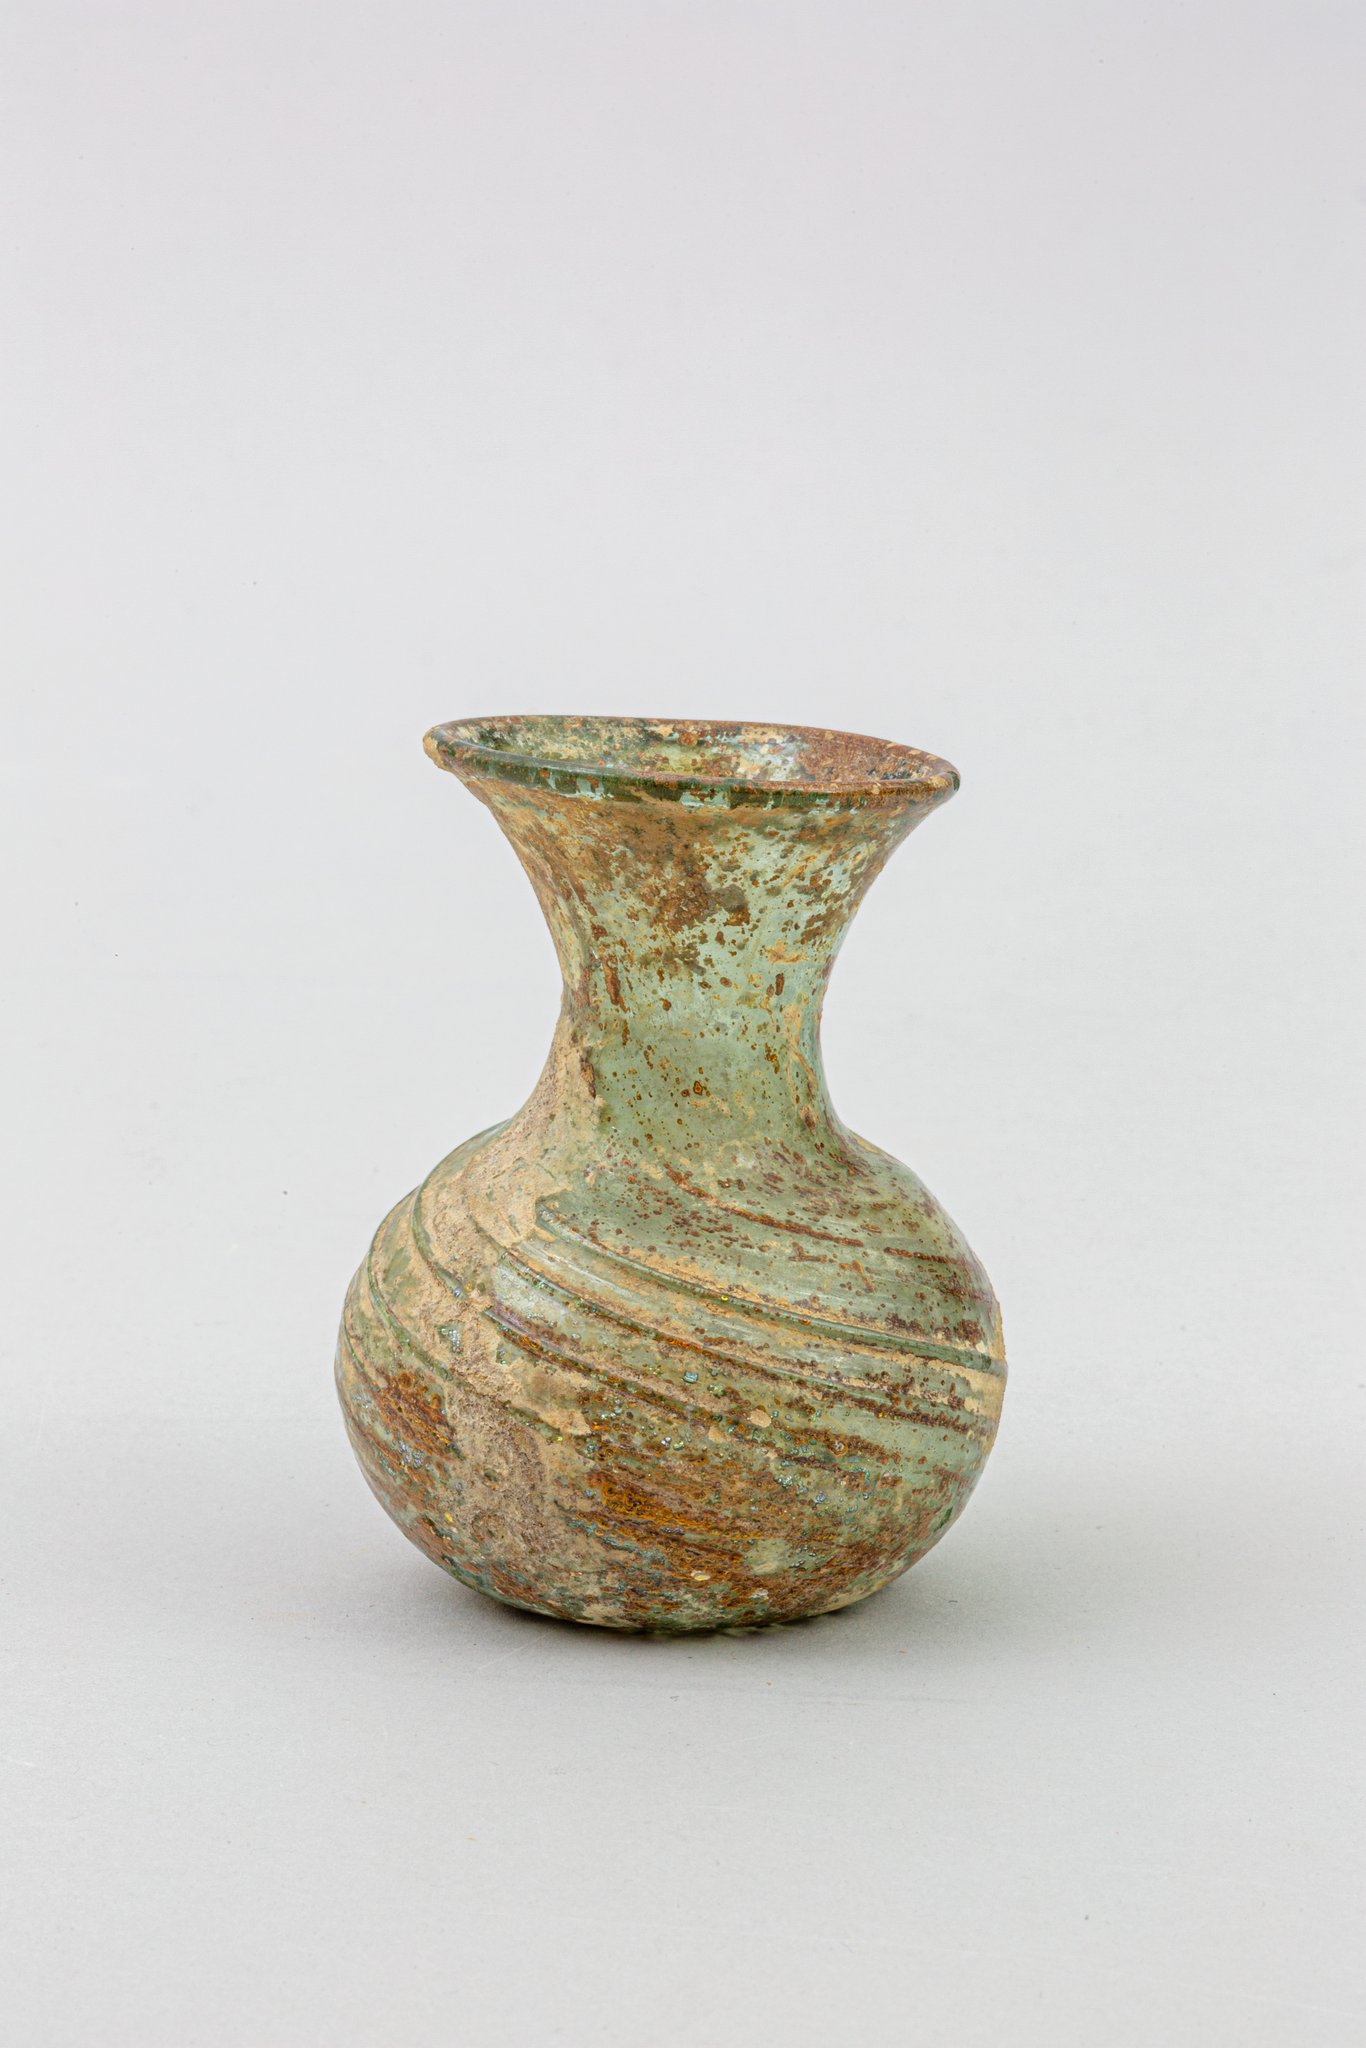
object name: jar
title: Glass jar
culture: roman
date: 201-400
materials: glass